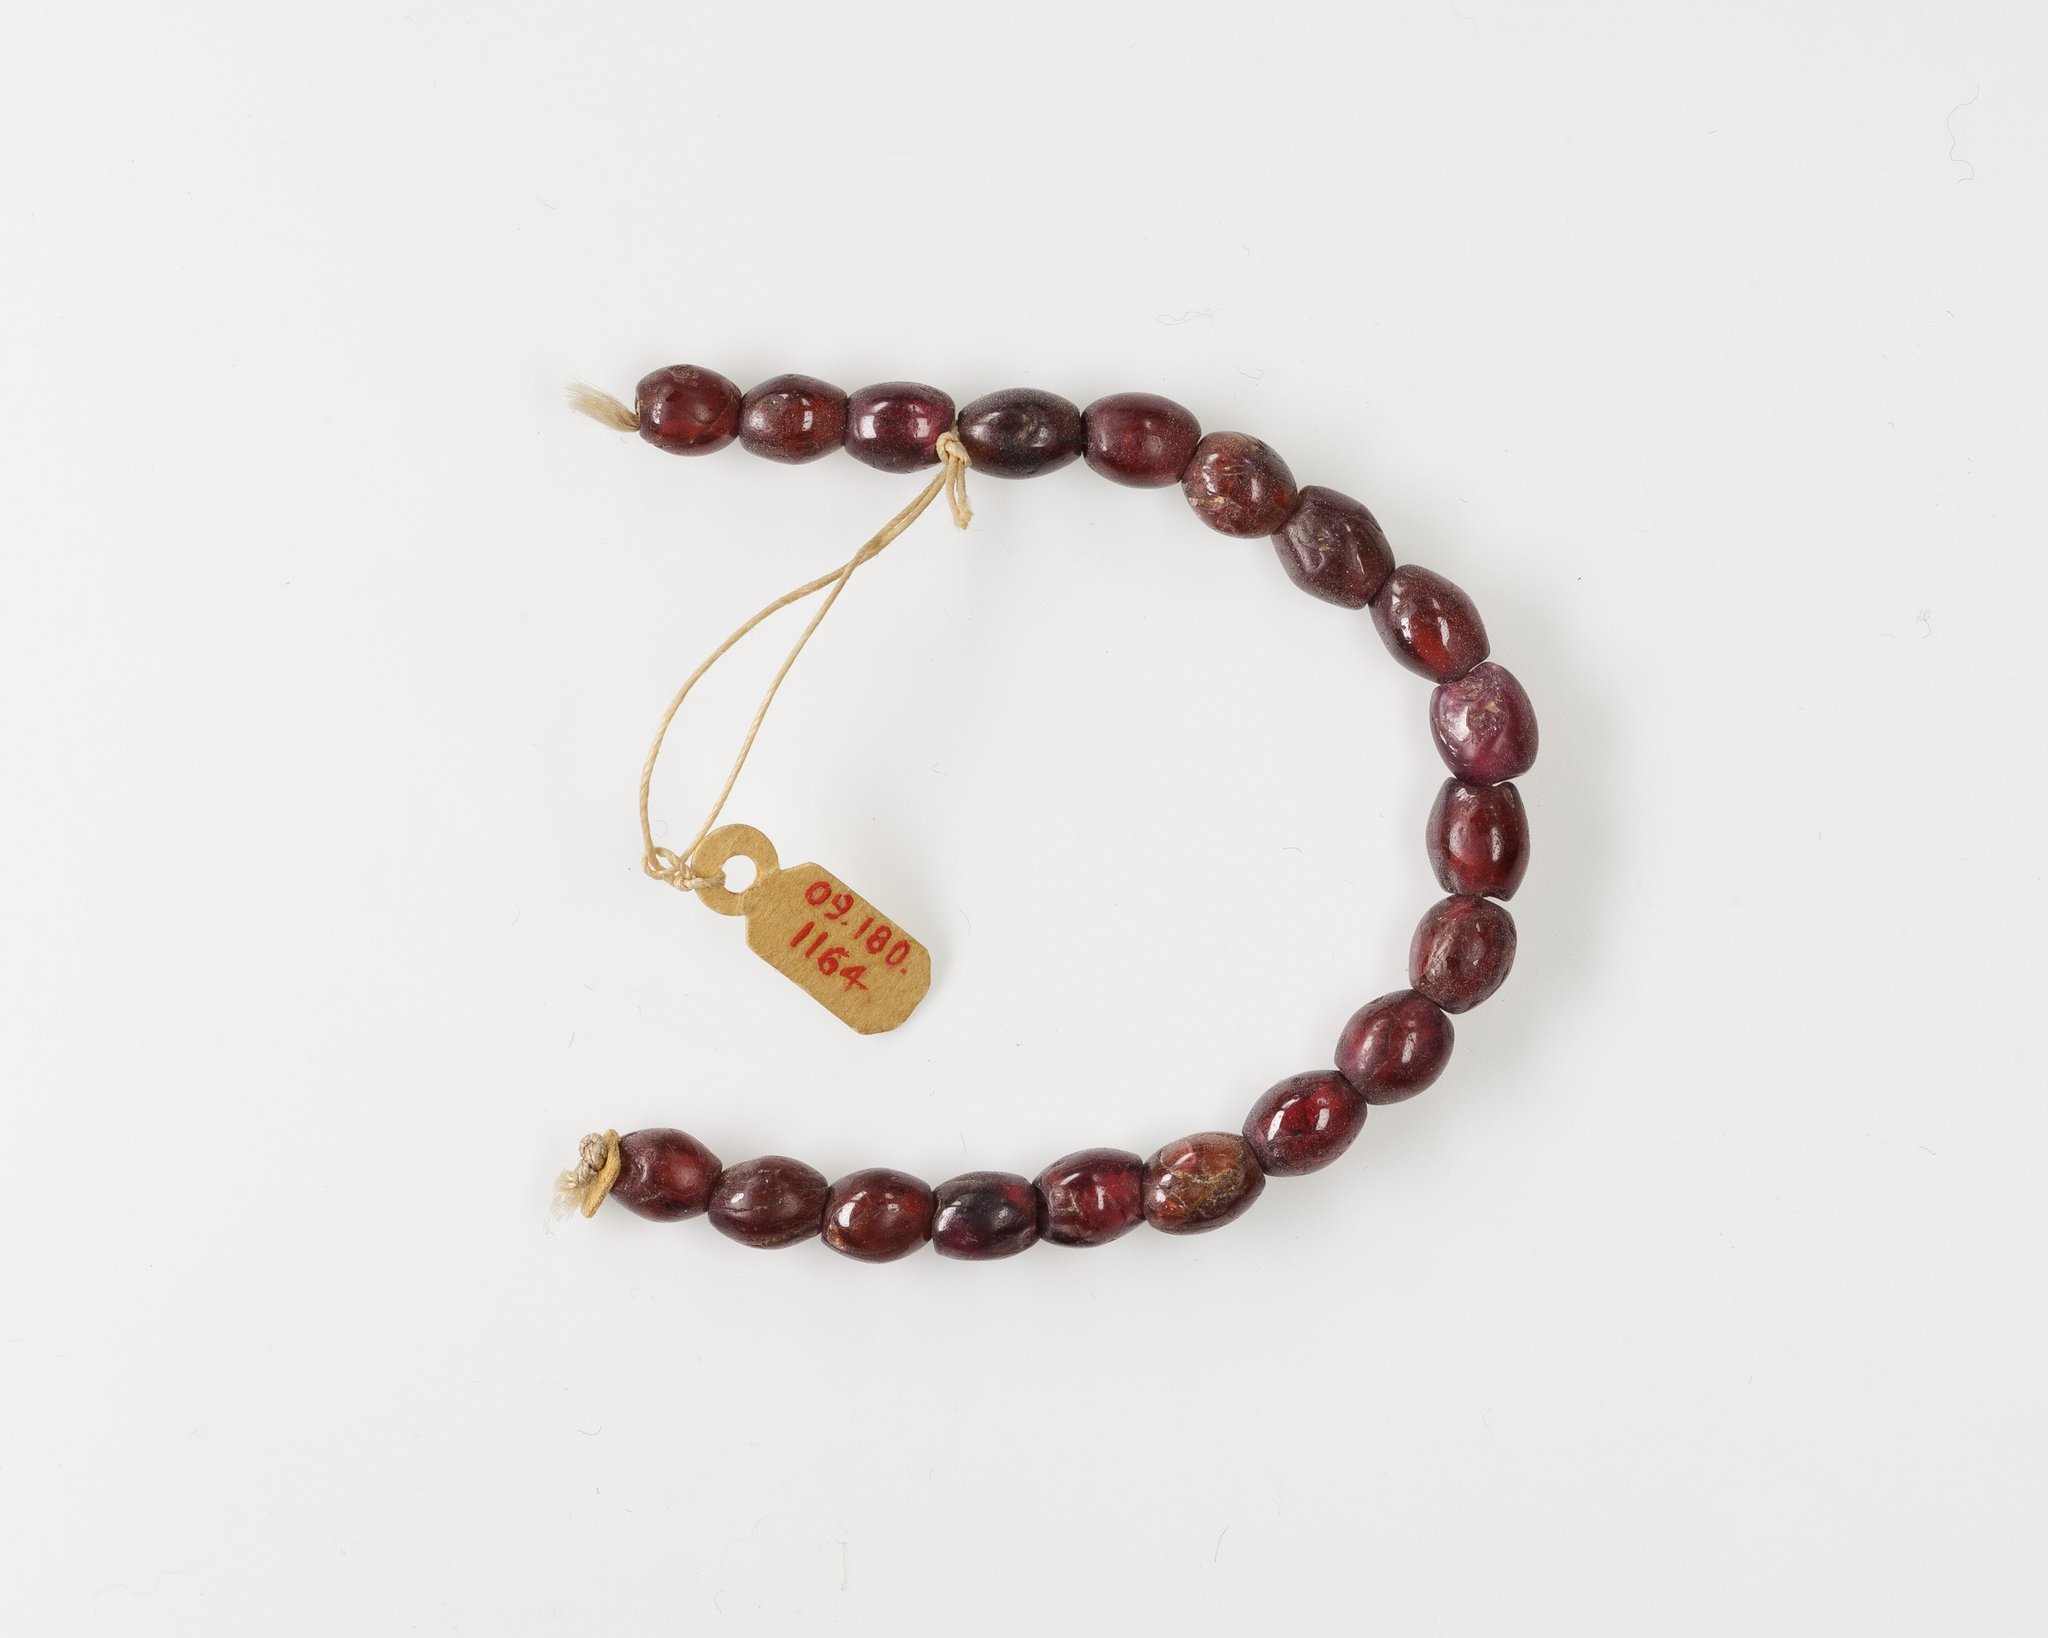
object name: bead, string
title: String of 19 beads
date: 1850-1750 BCE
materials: gemstone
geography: egypt